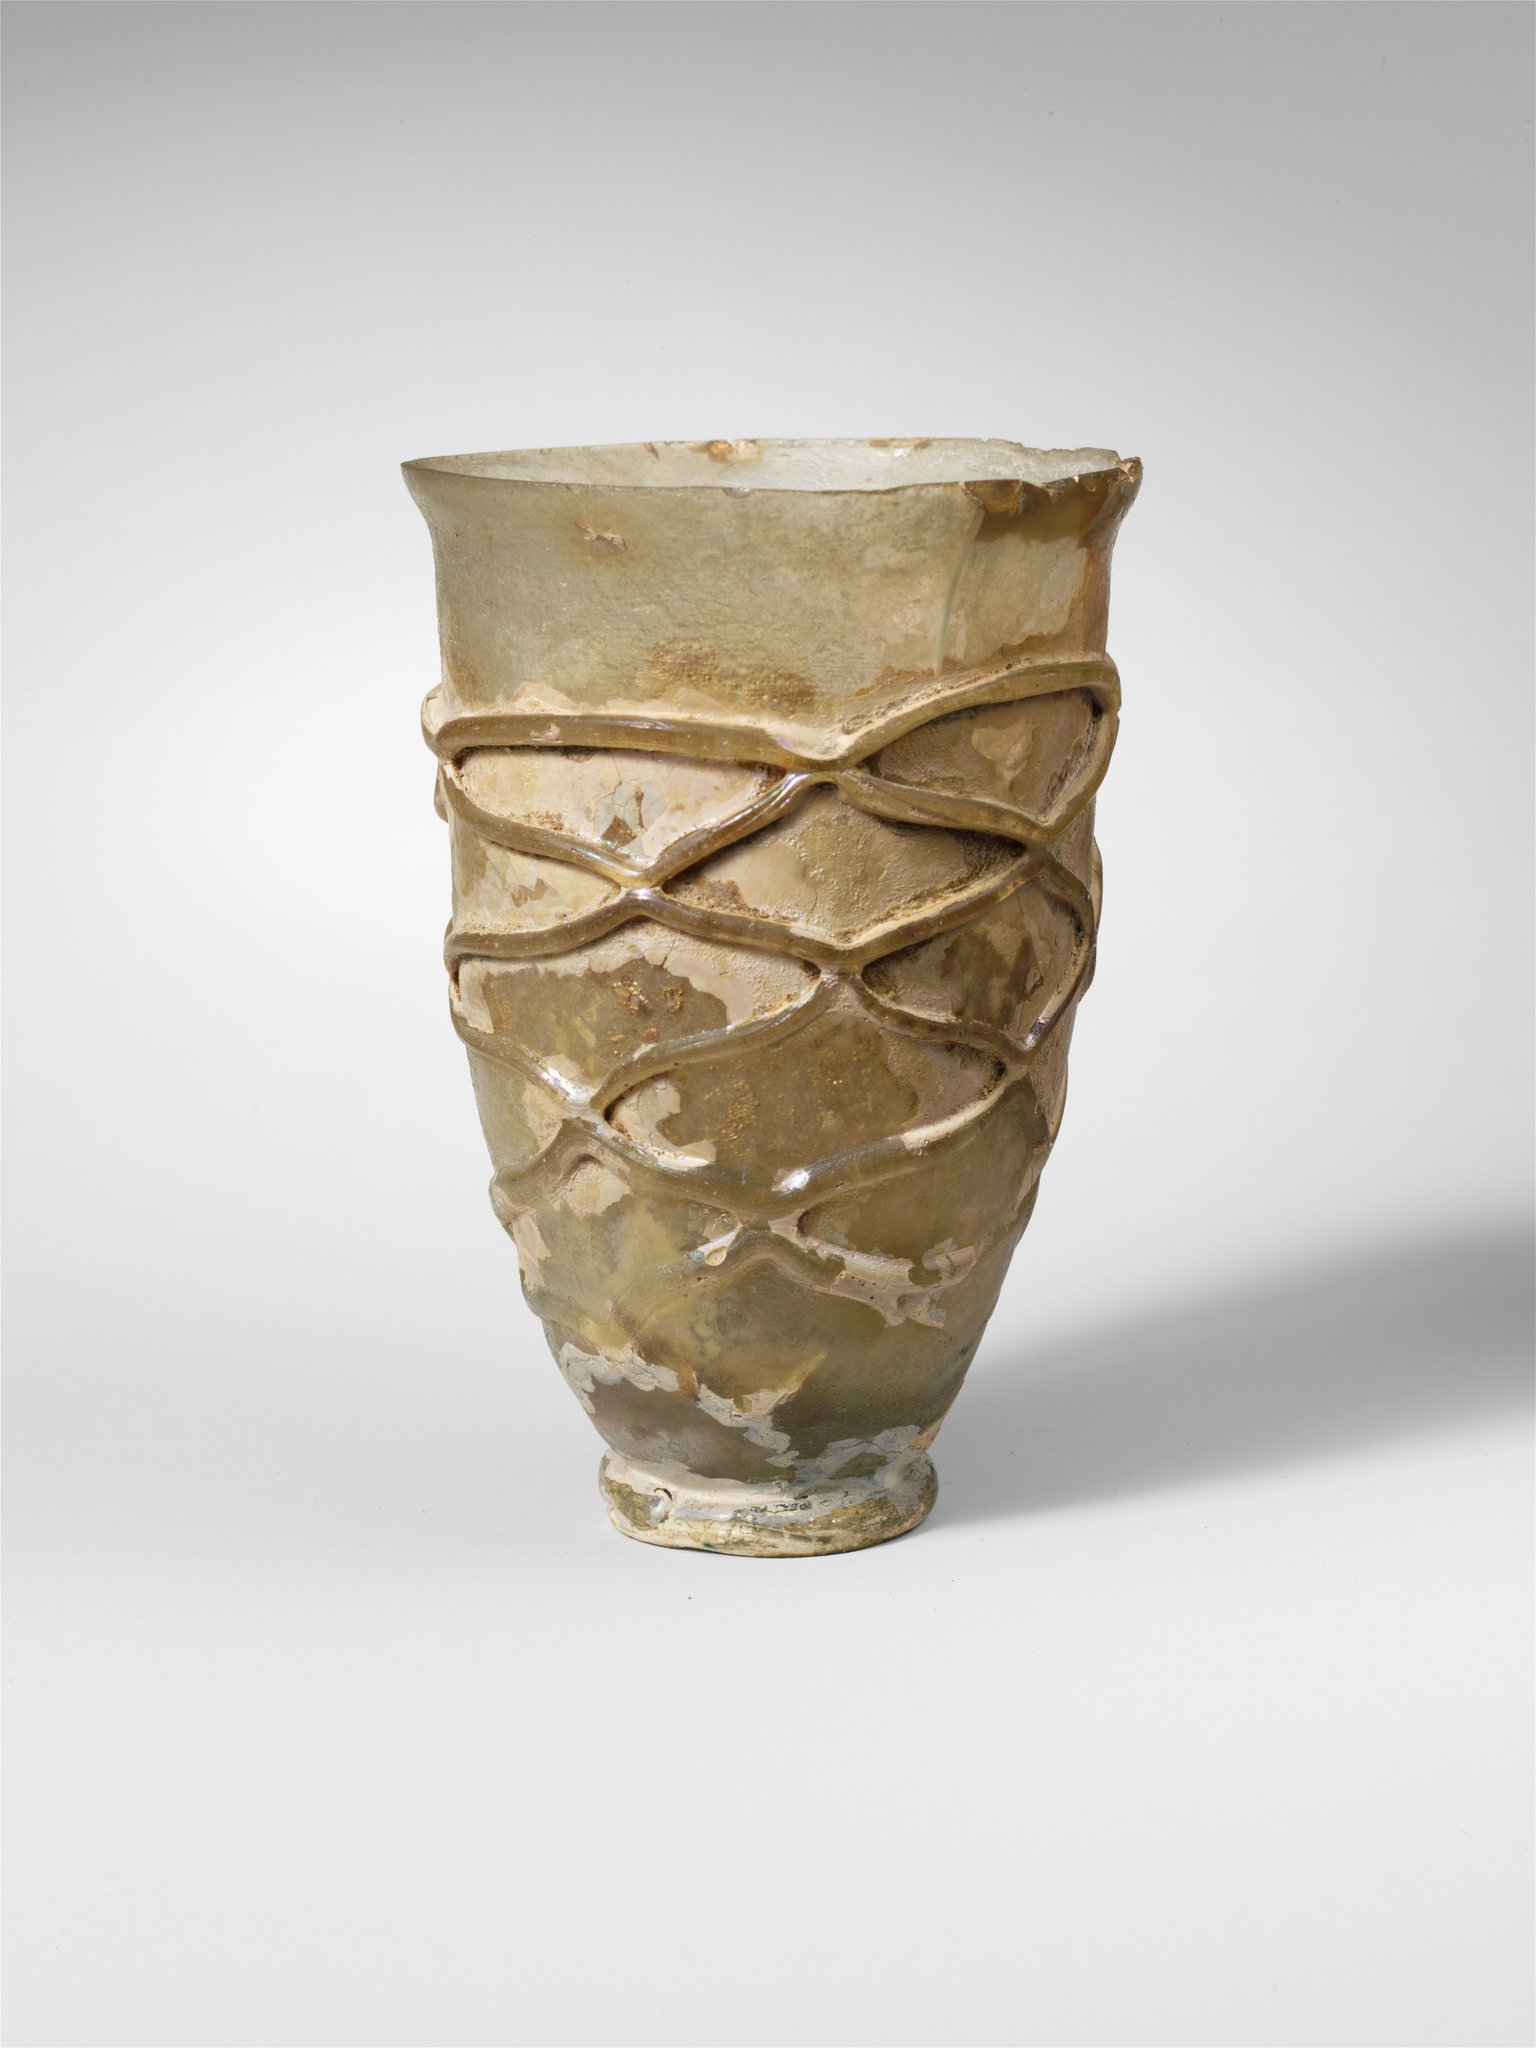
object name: beaker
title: Glass beaker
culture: roman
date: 167-300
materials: glass